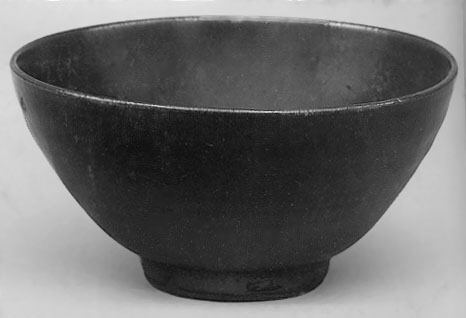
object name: teabowl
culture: japanese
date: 1801-1900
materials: clay, glaze